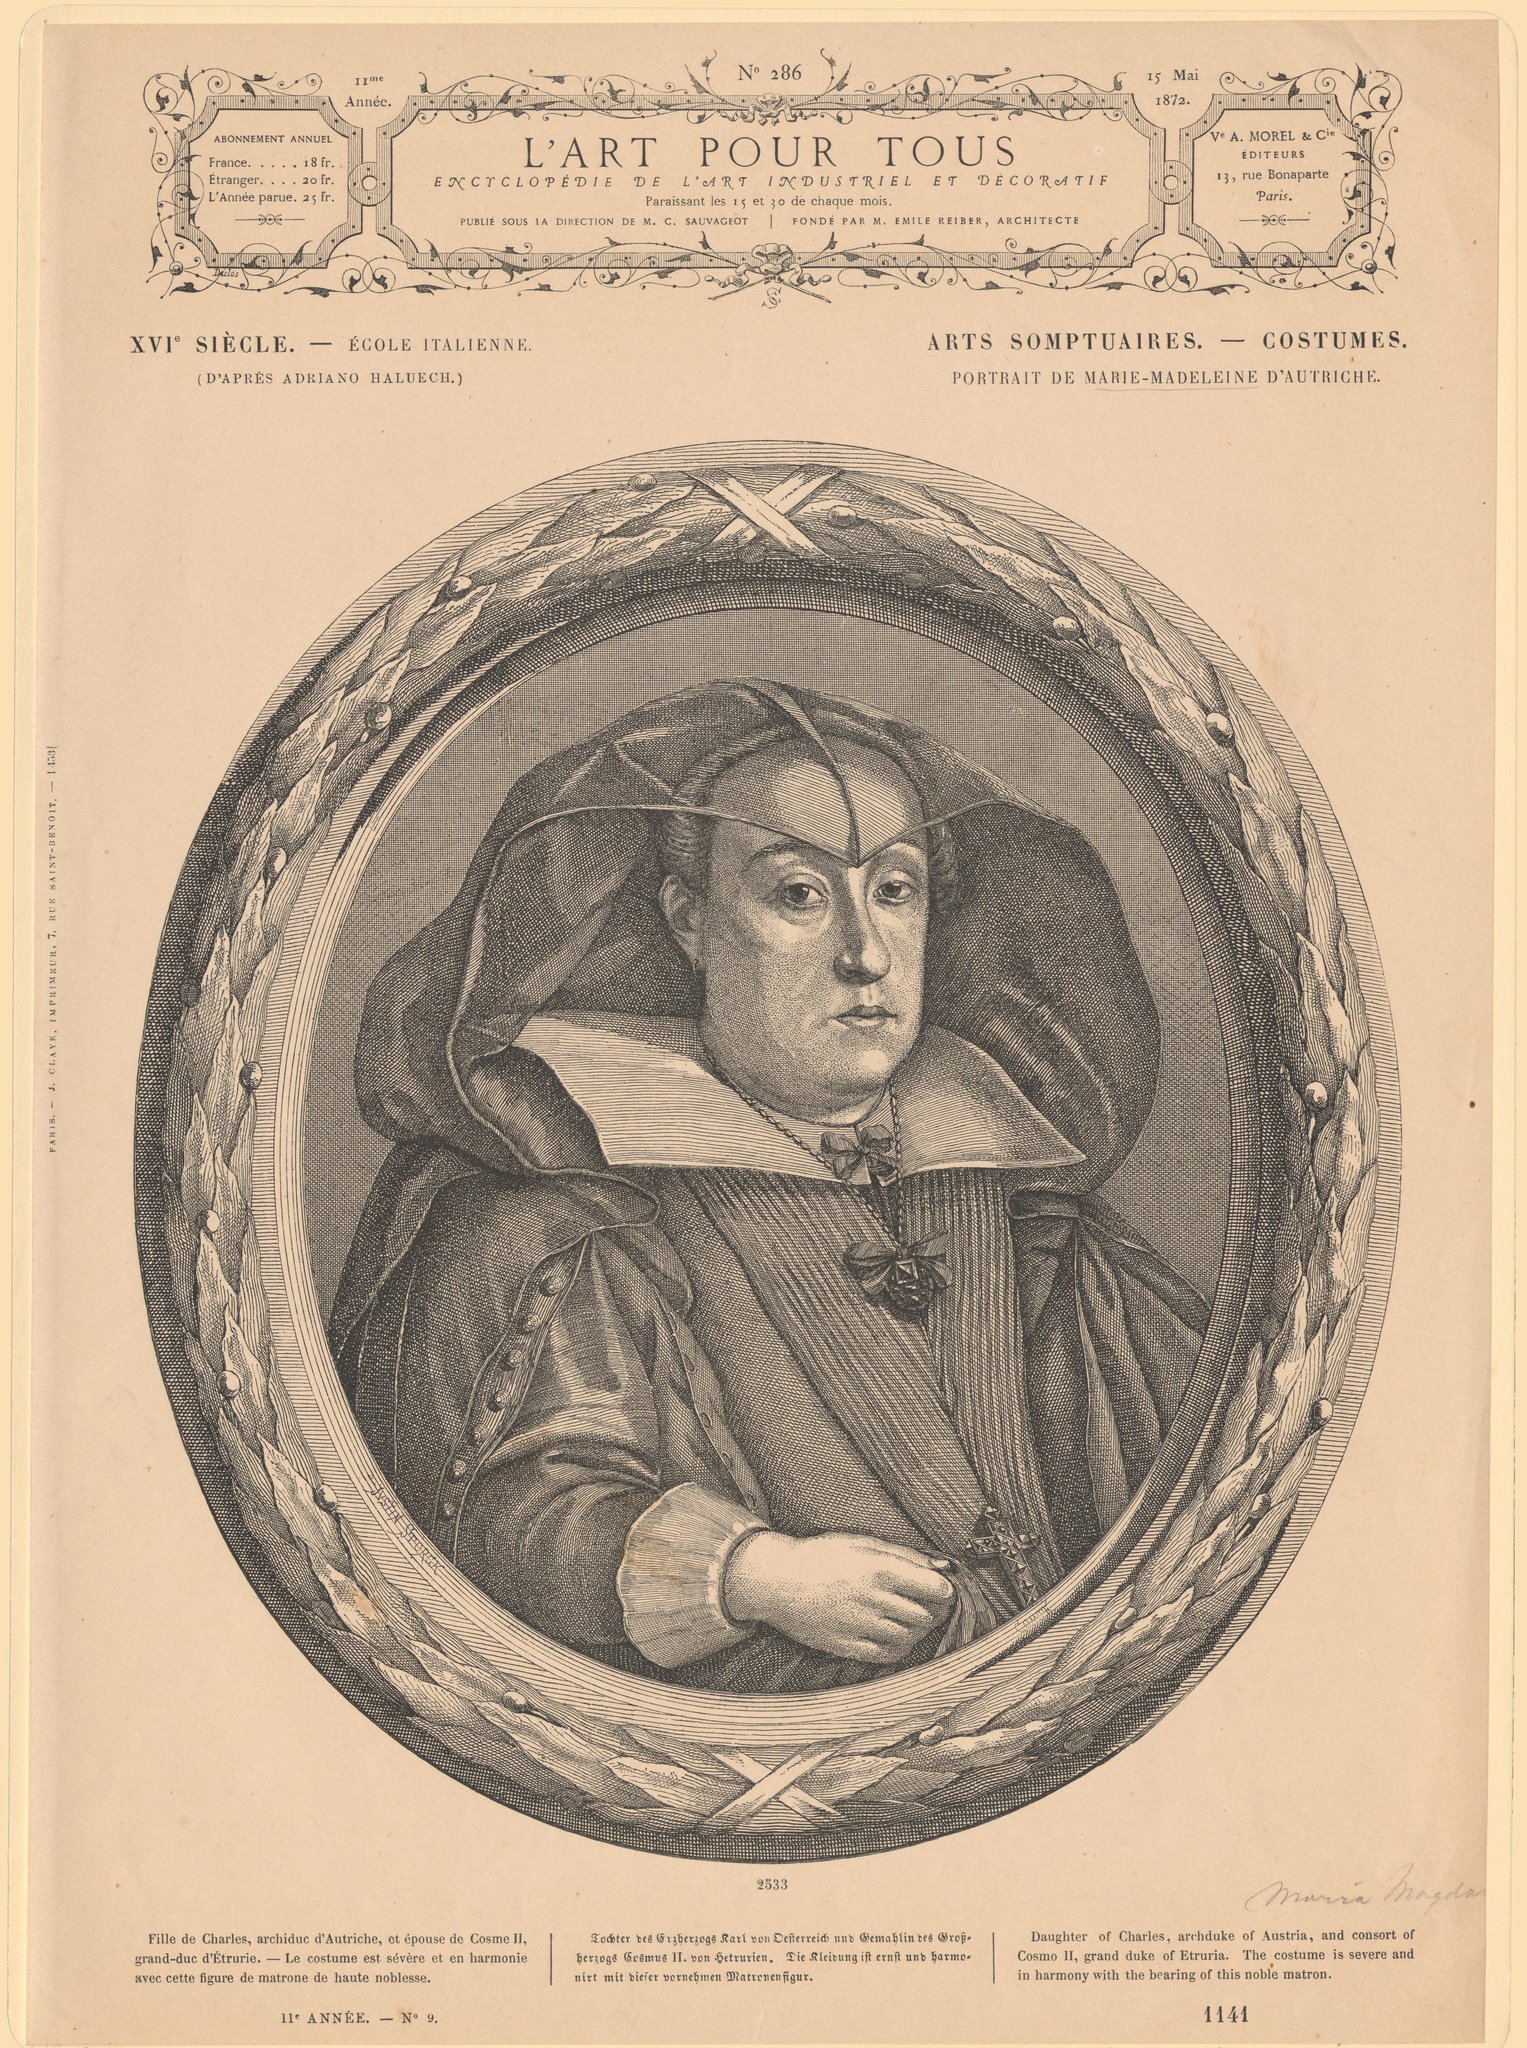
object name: photomechanical print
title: Portret van Maria Magdalena van Oostenrijk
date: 1872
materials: paper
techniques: letterpress printing, line block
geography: paris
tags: historical persons - bb - woman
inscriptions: collector's mark: Lugt 3937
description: Tekstblad uit: L'Art Pour tous 11 (1872), nr. 286, 15 mei 1872.